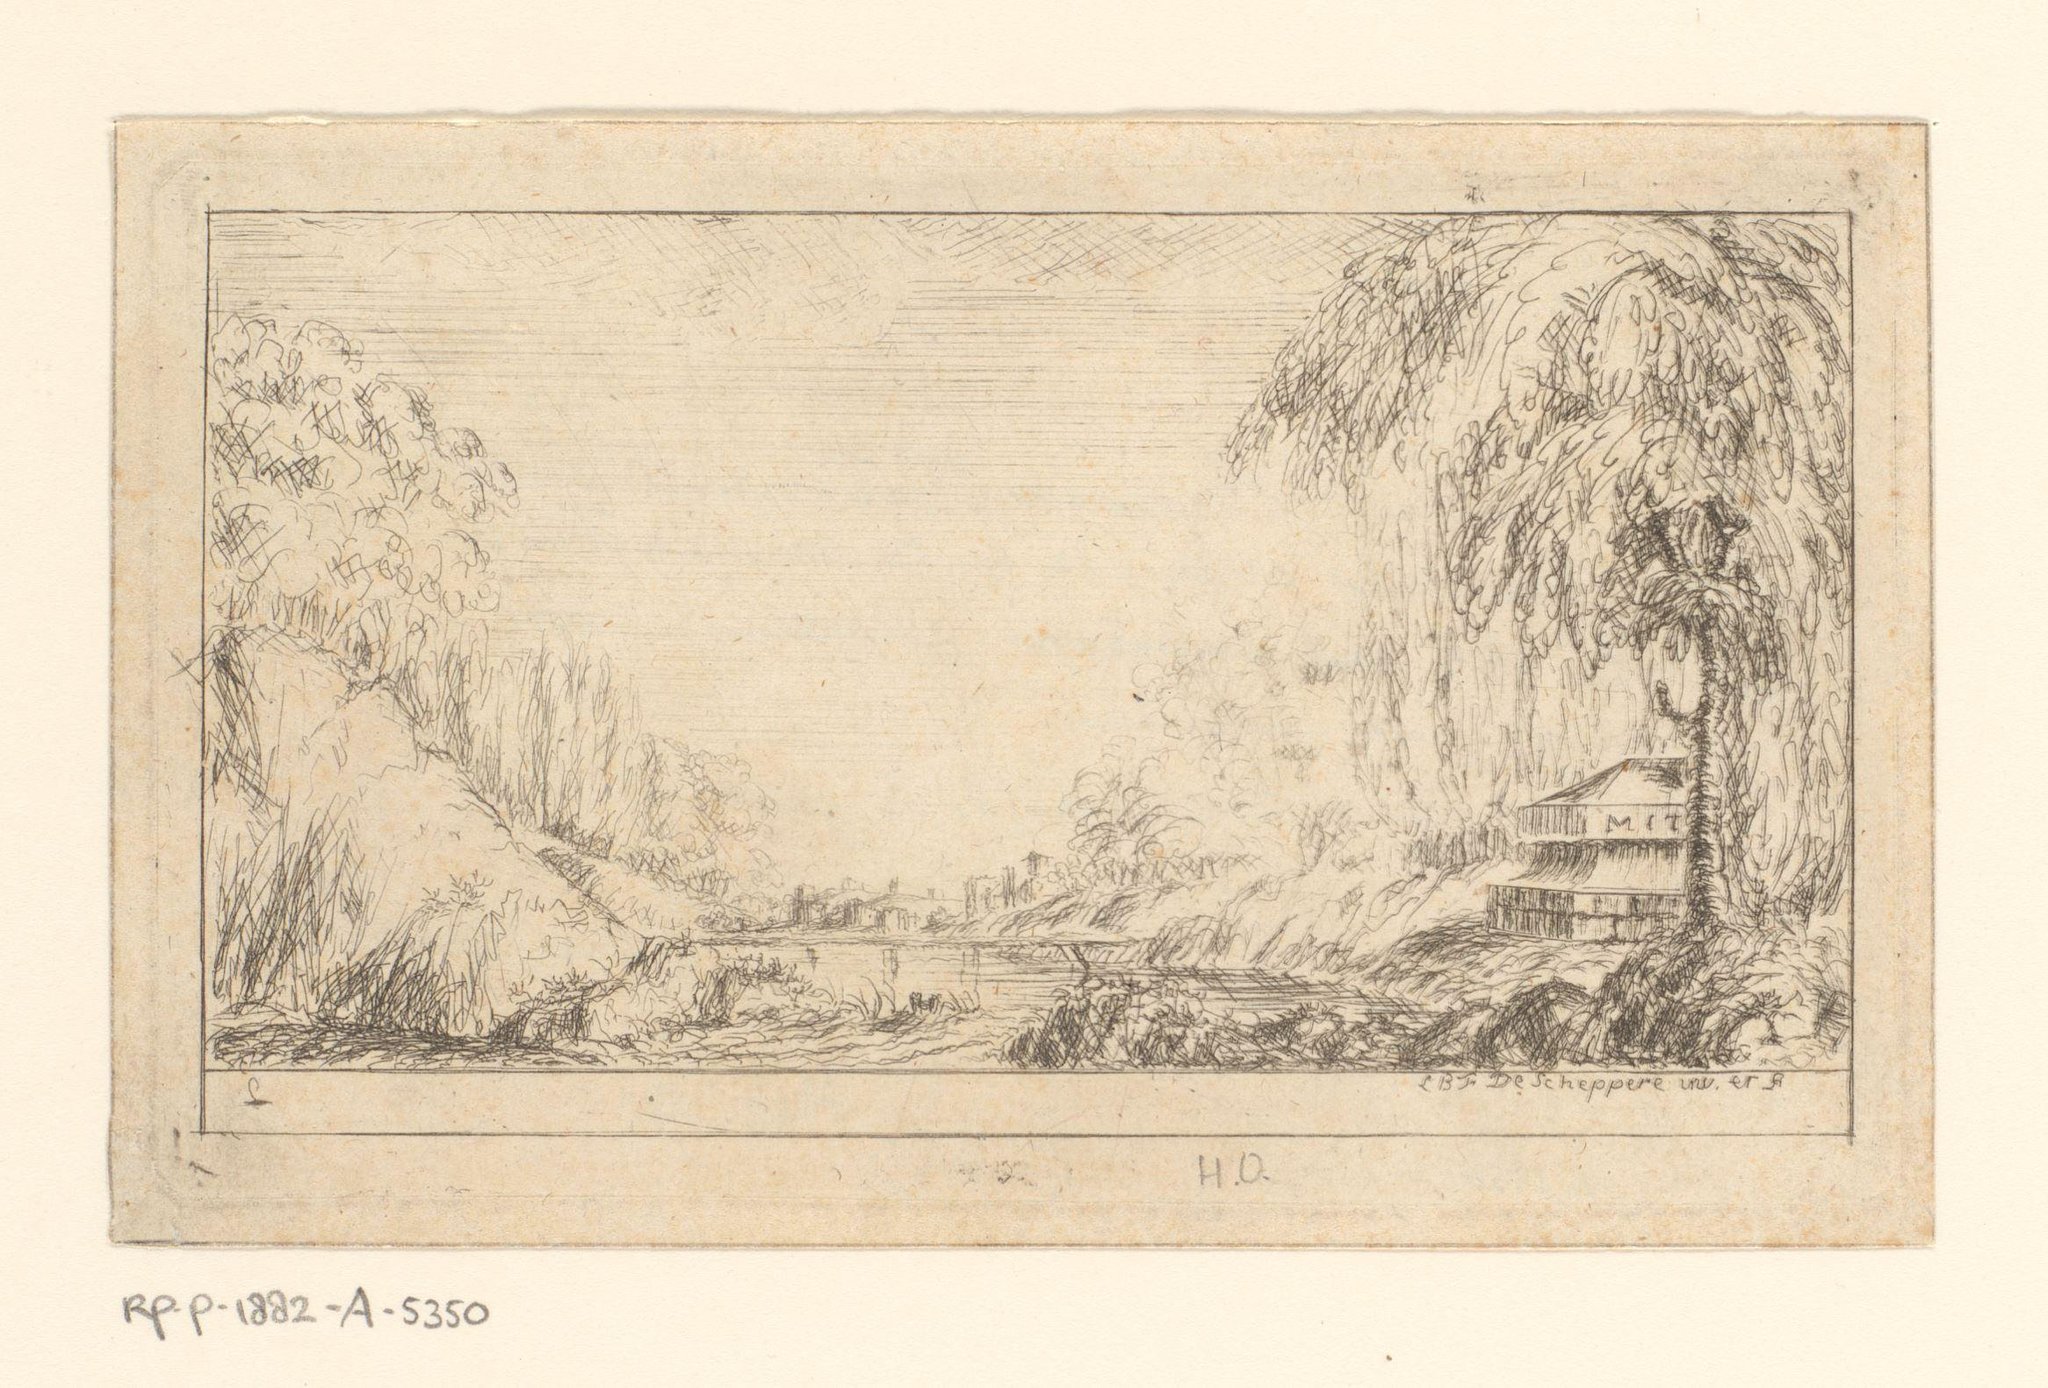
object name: print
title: Landschap met rechts van een brug een graftombe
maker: louis benoît ferdinand de scheppere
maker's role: print maker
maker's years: 1748-1811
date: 1802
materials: paper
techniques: etching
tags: grave, tomb, landscape with monument, bridge, water course (+ landscape with figures, staffage)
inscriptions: inscription: ‘[Descheppere, Louis Benoit Ferdinand Descheppere. ne à Bruxelles et decide en la même villes en 1811 au 18e agé de 63 ans environ. Amateur. Etait employe sous le gouvernement [...] 1e Etat, non terminée, de la planche]’, collector's mark: Lugt 2228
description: Linksonder genummerd: 2 (achterstevoren).